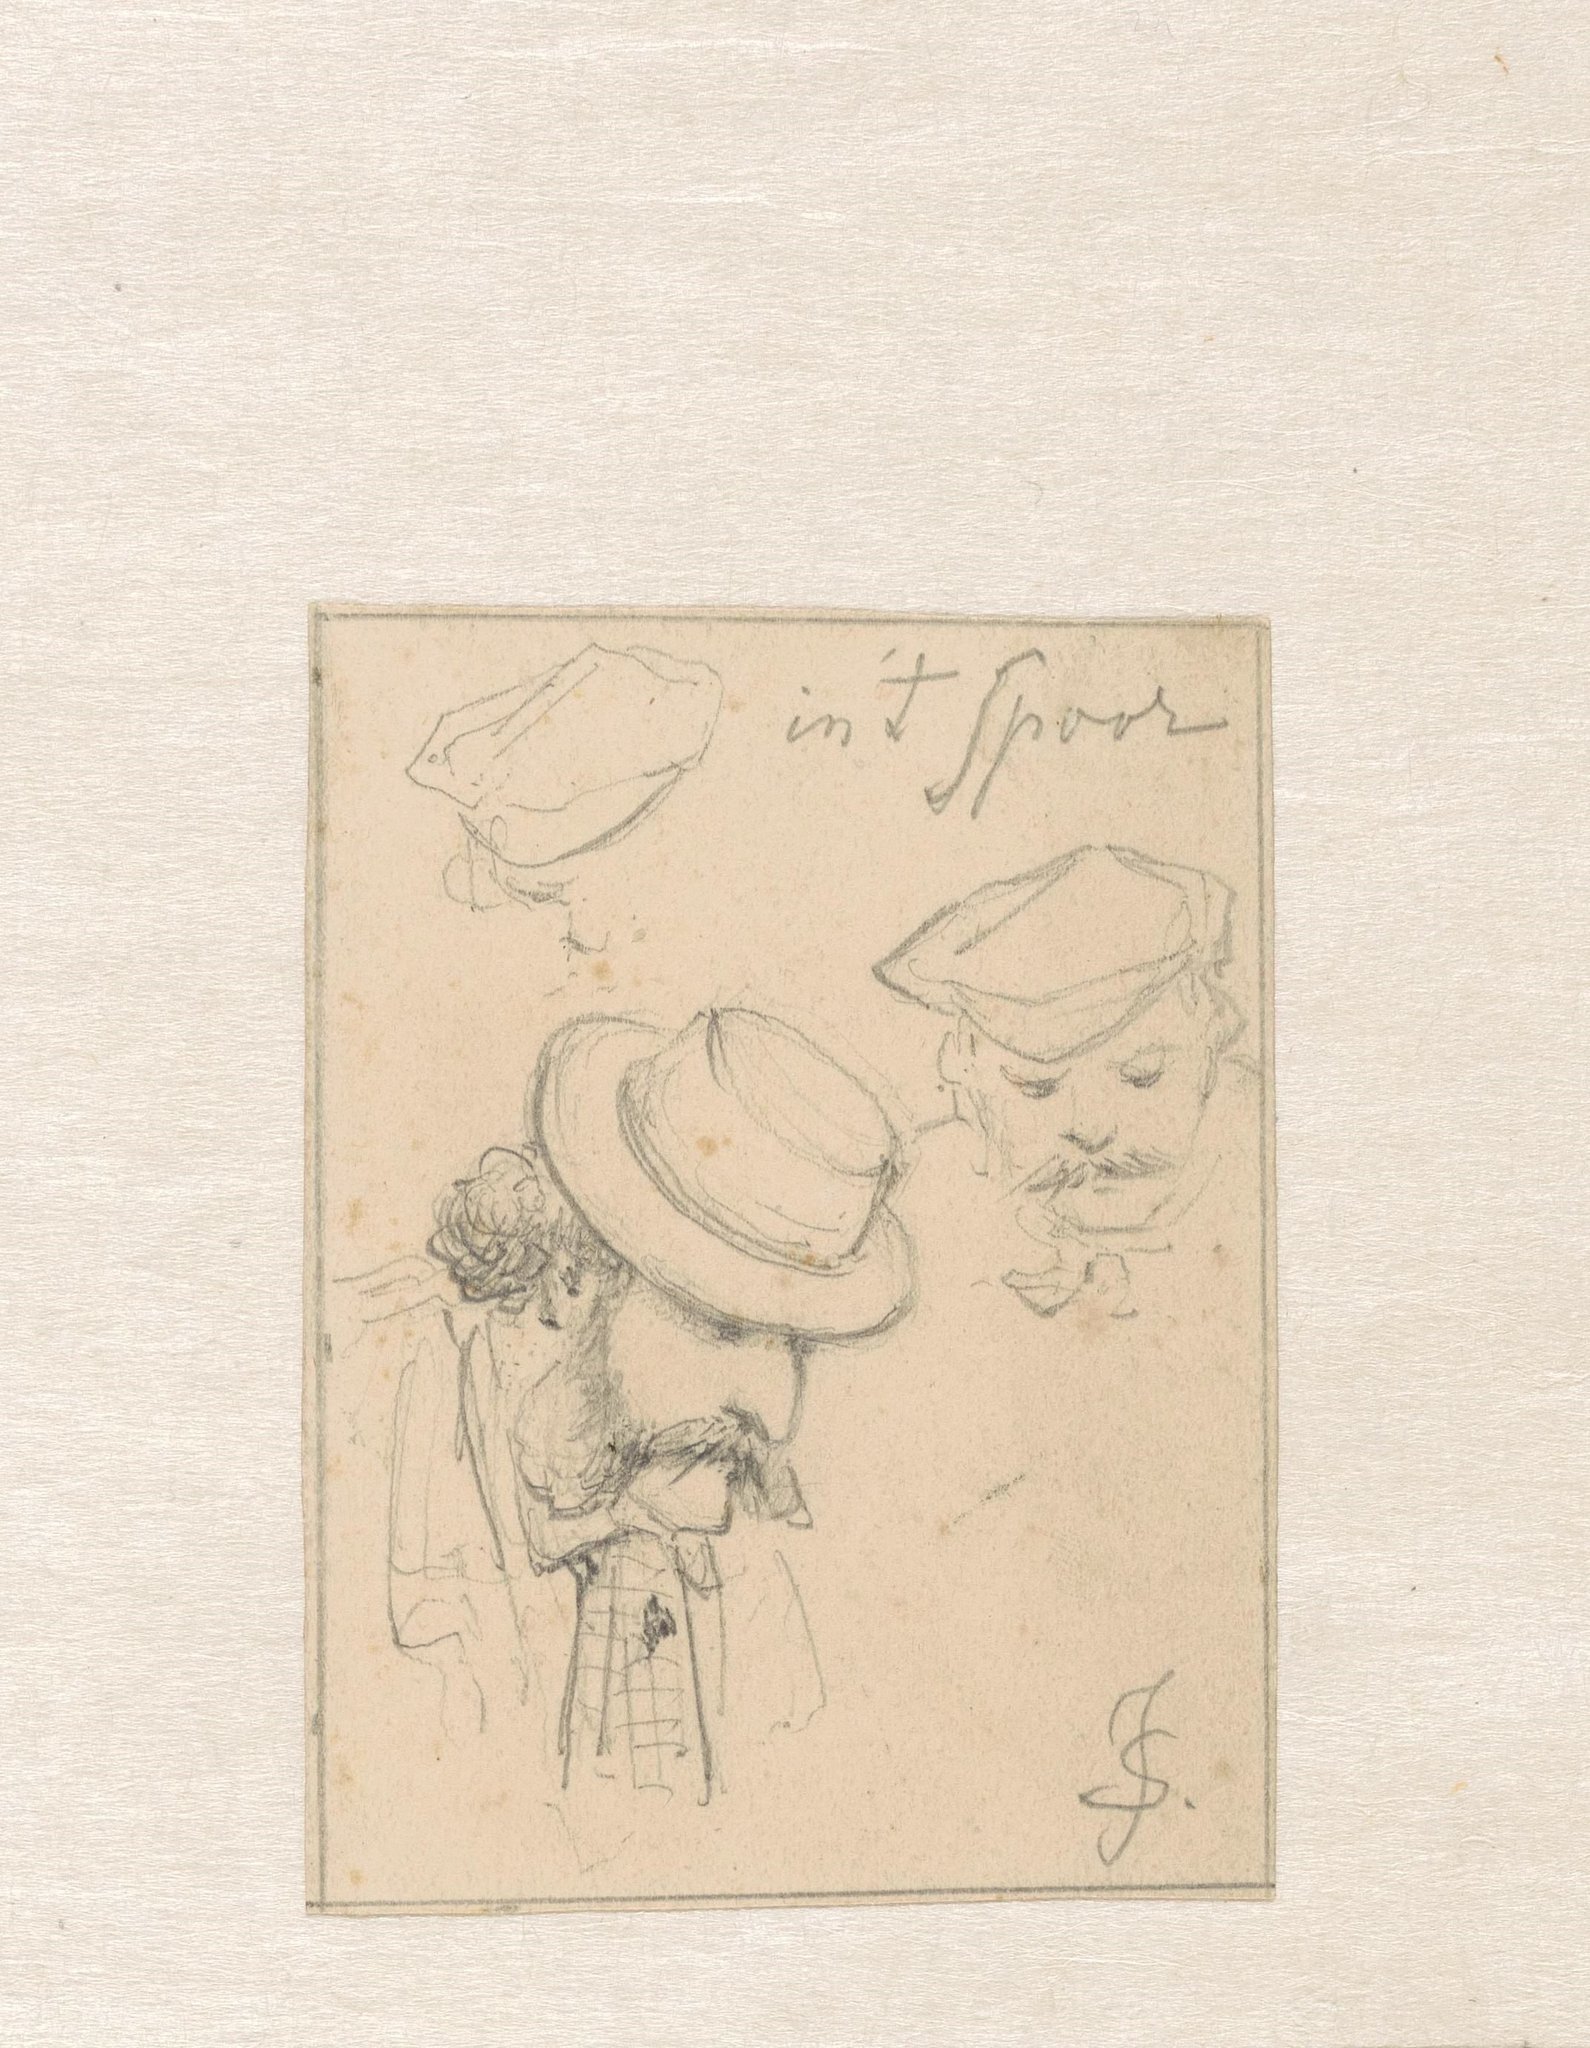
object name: drawing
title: Reizigers in de trein tijdens de Duitse reis van 1864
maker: jan striening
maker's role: draughtsman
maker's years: 1827-1903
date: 1837-1903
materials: paper, pencil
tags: germany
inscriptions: inscription: ‘In 't Spoor’